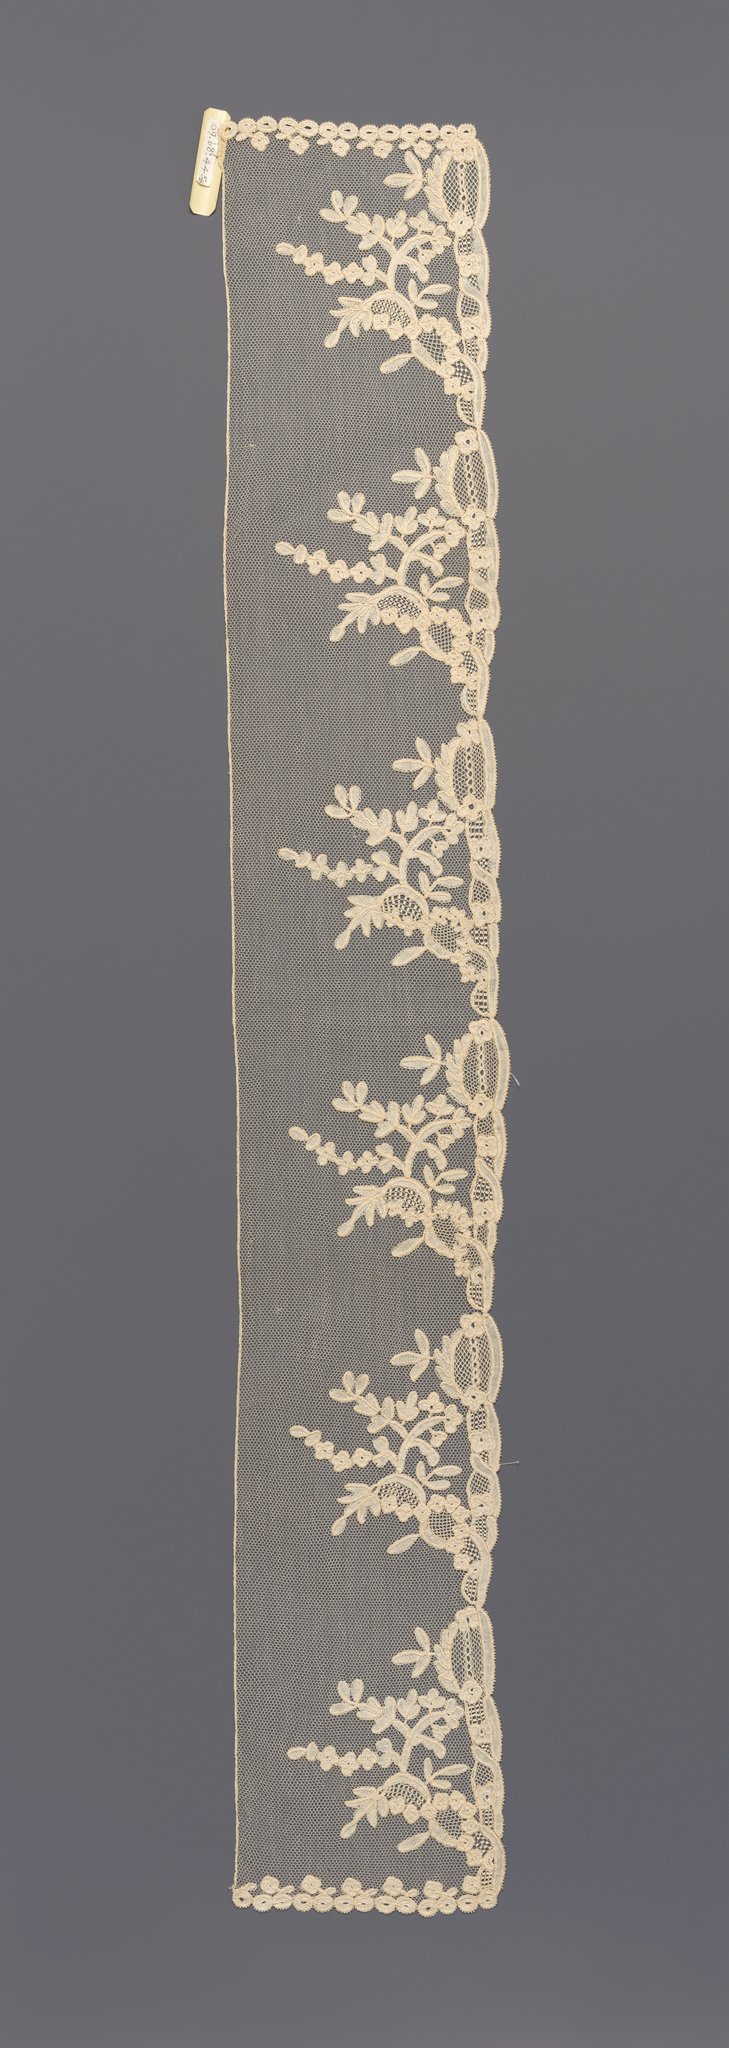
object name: fragment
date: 1801-1900